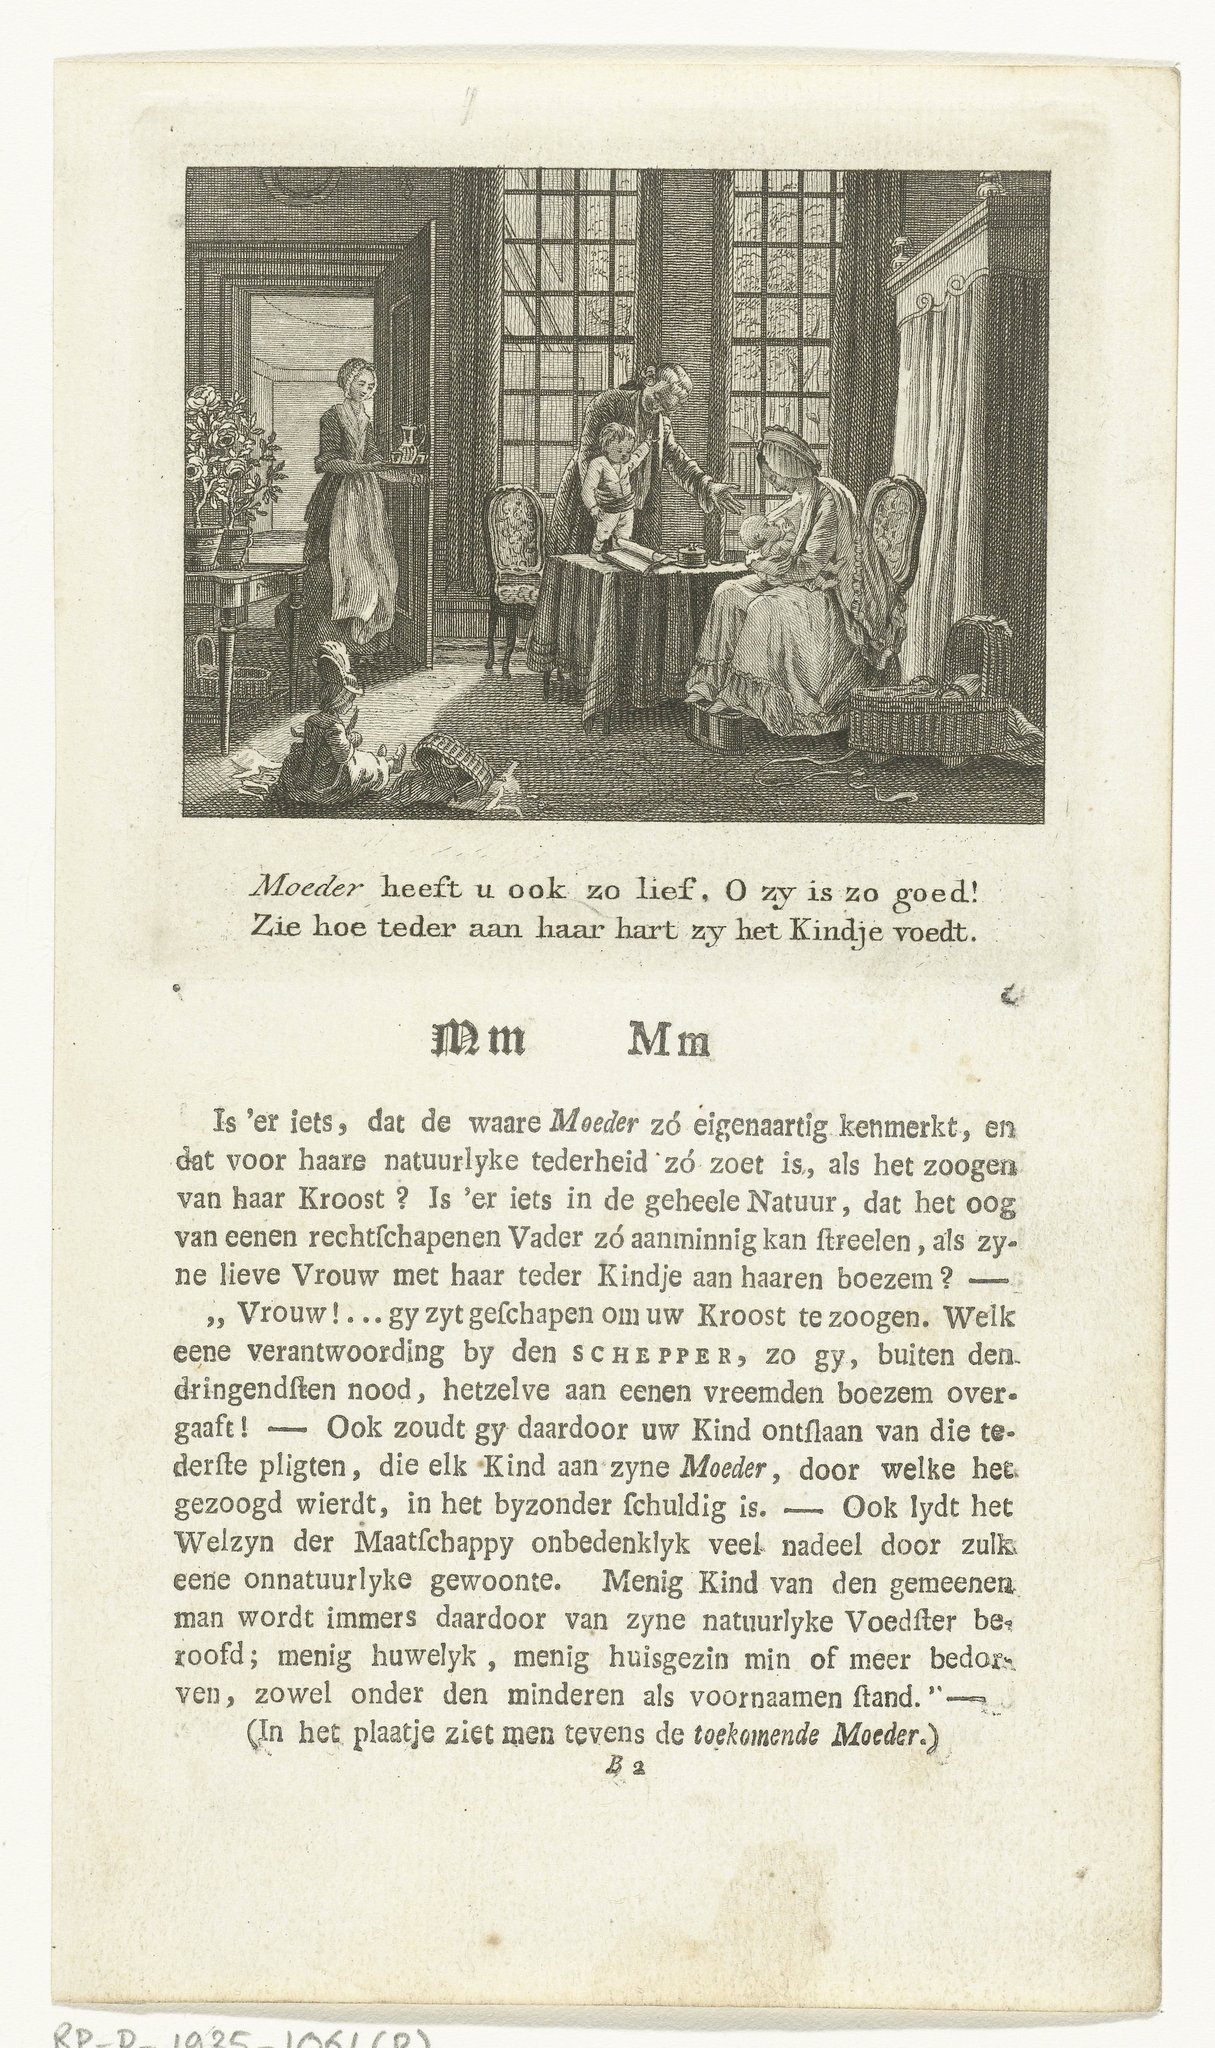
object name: print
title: Voedende moeder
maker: cornelis bogerts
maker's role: print maker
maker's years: 1745-1817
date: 1781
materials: paper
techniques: etching, letterpress printing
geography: amsterdam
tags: feeding a baby, motherhood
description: Letter M uit het Vaderlandsch A-B boek van J.H. Swildens. Een moeder zit in de kinderkamer haar baby te voeden. Haar man houdt een tweede kind in zijn armen. Op de grond speelt het derde kind. De meid komt met iets te drinken de kamer binnen lopen. Onder de prent een vers en een tekst op de moederliefde en het belang van borstvoeding.